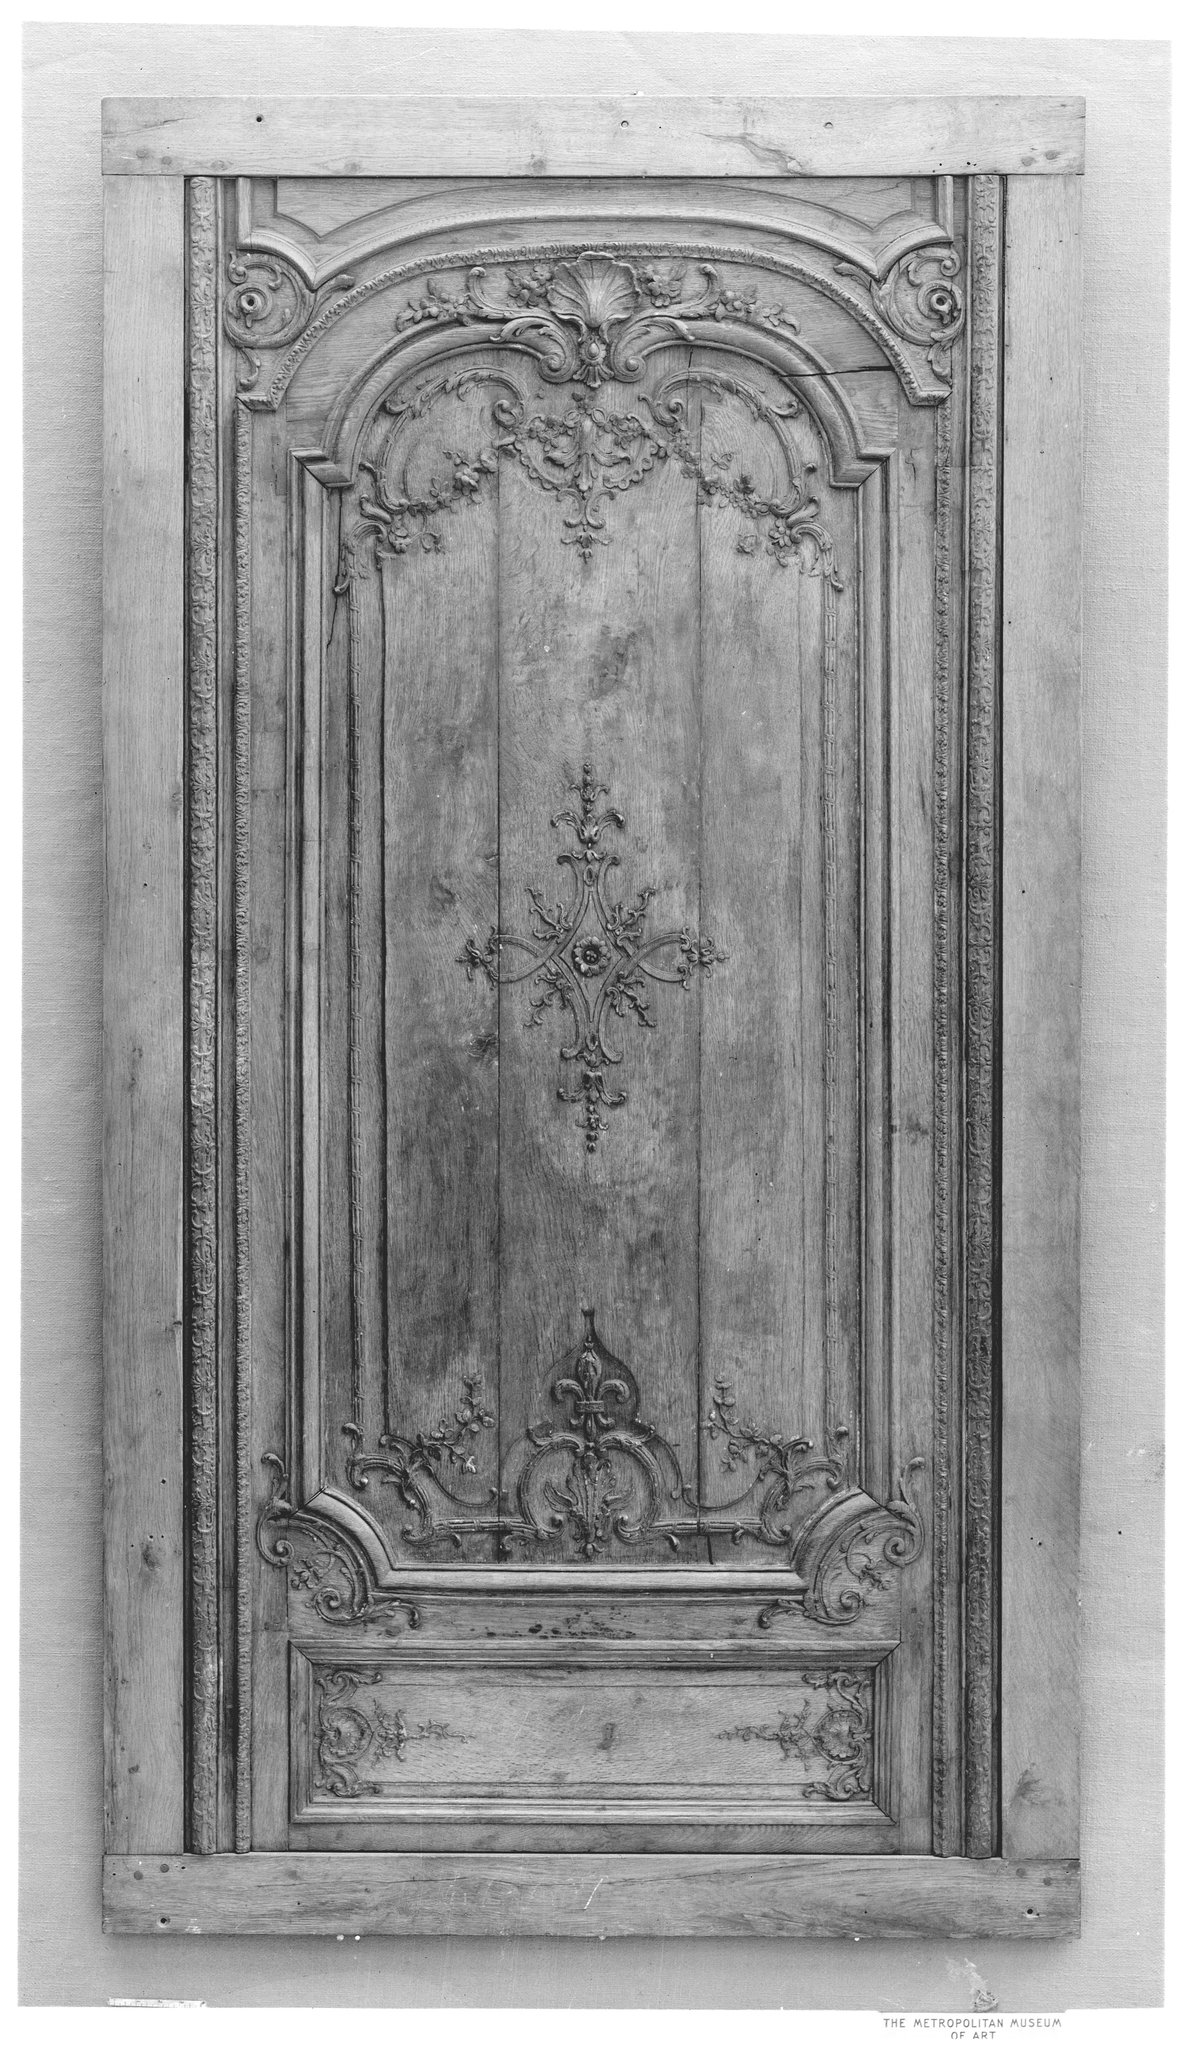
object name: door panel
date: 1701-1800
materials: wood